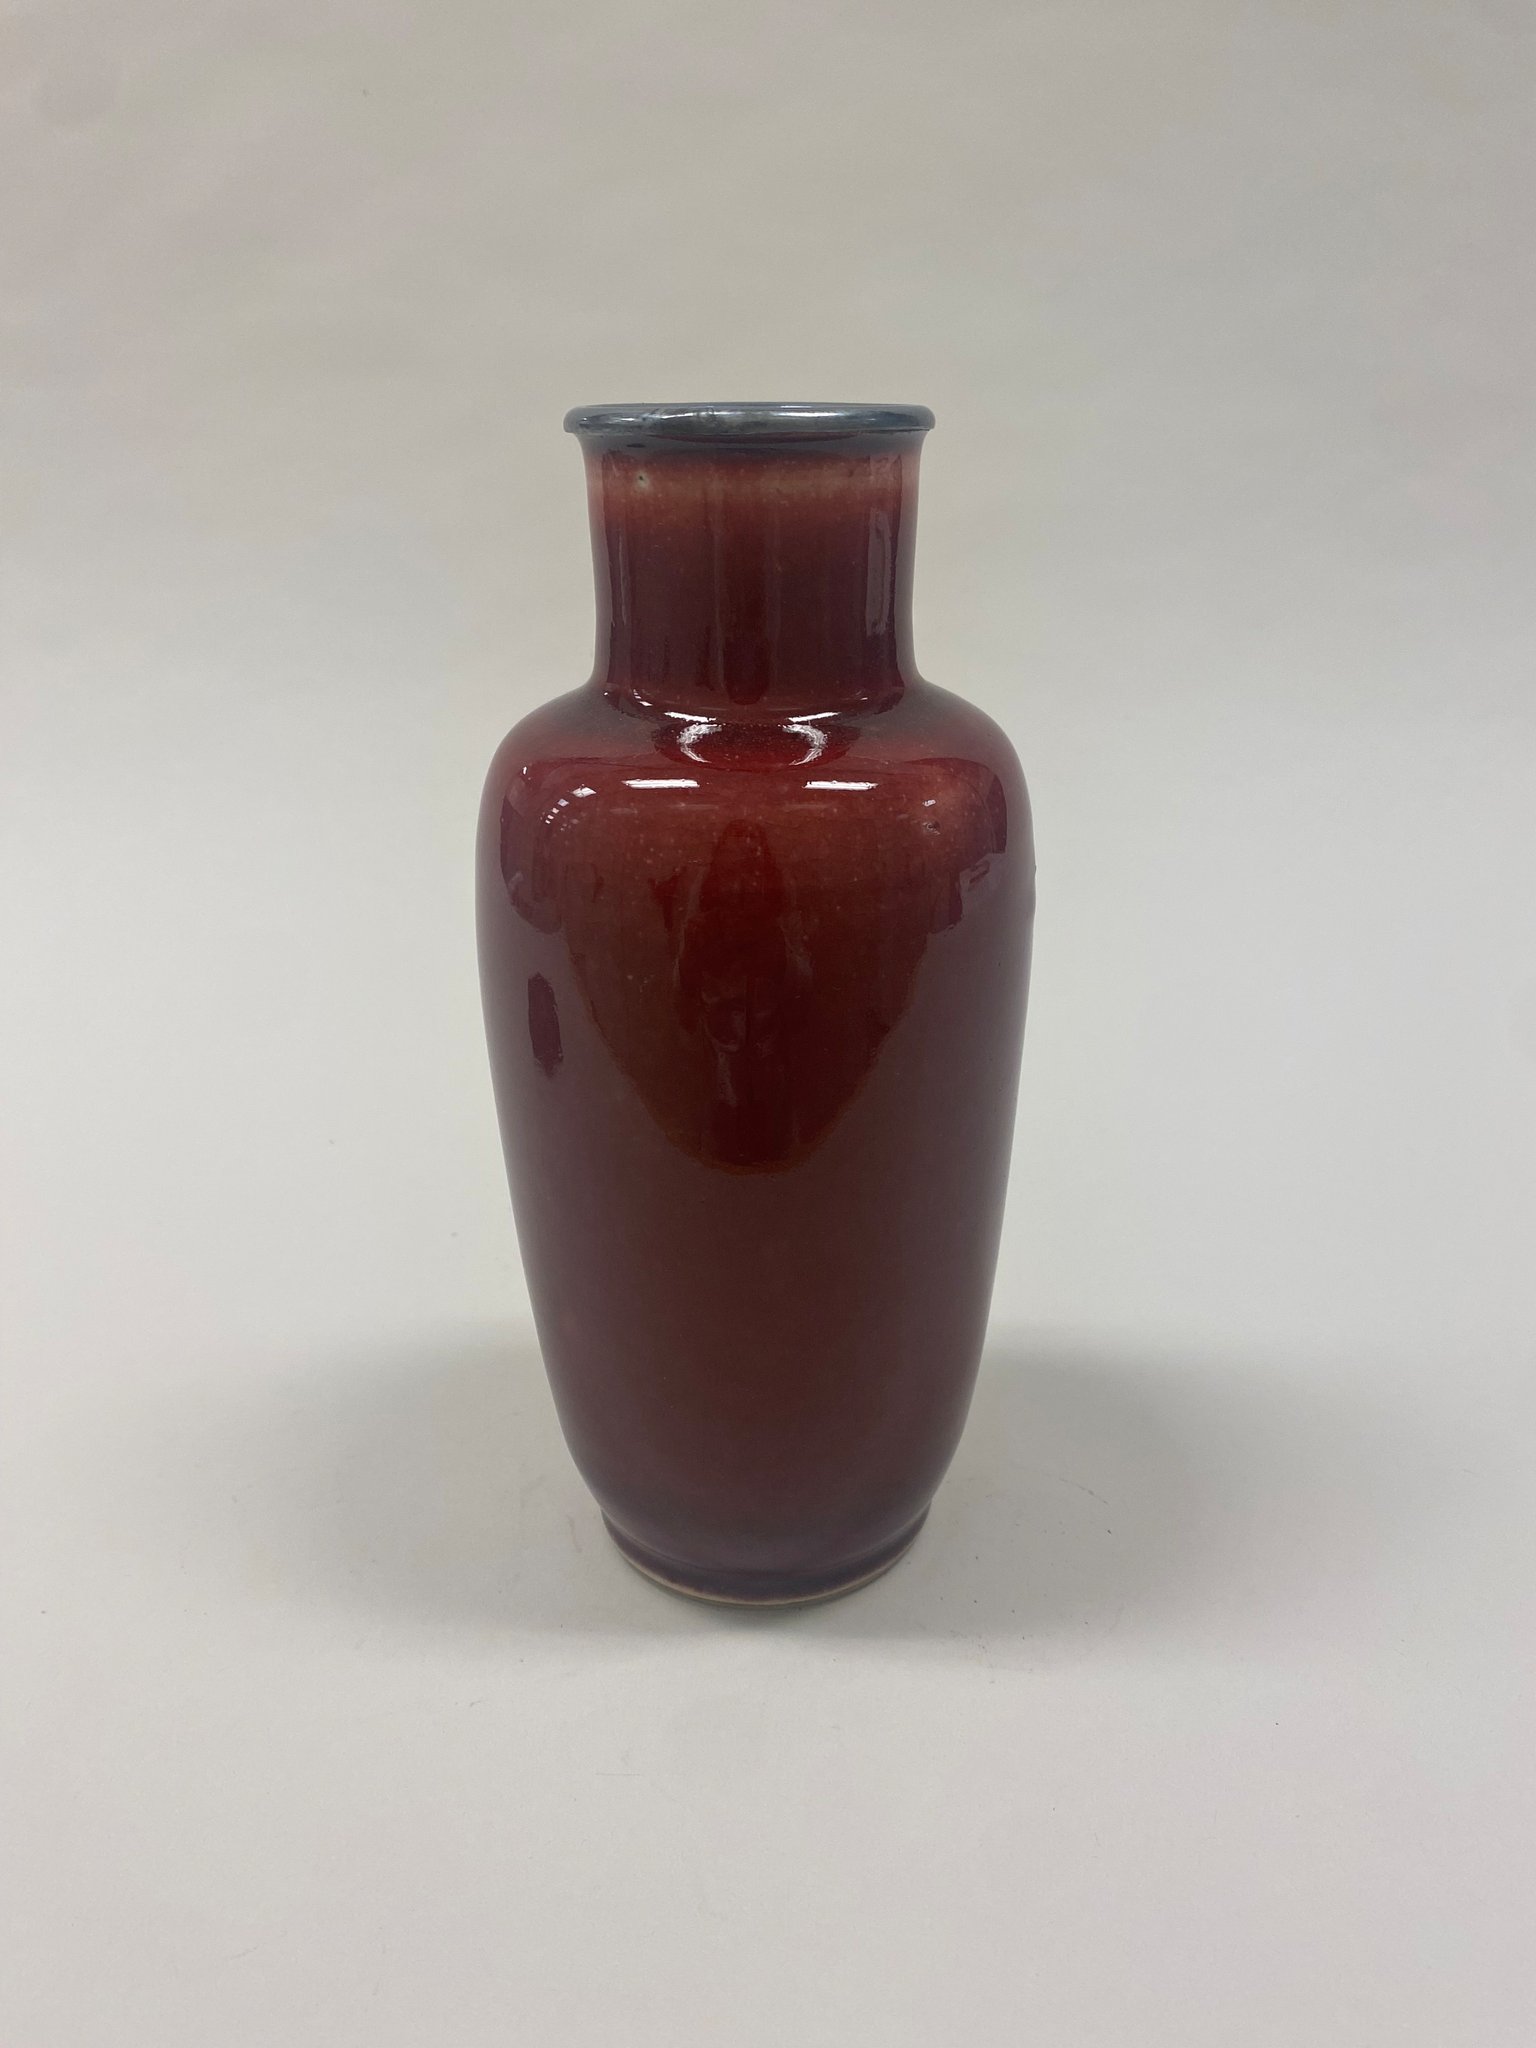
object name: vase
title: Mallet-shaped vase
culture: chinese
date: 1667-1733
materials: copper, glaze, porcelain